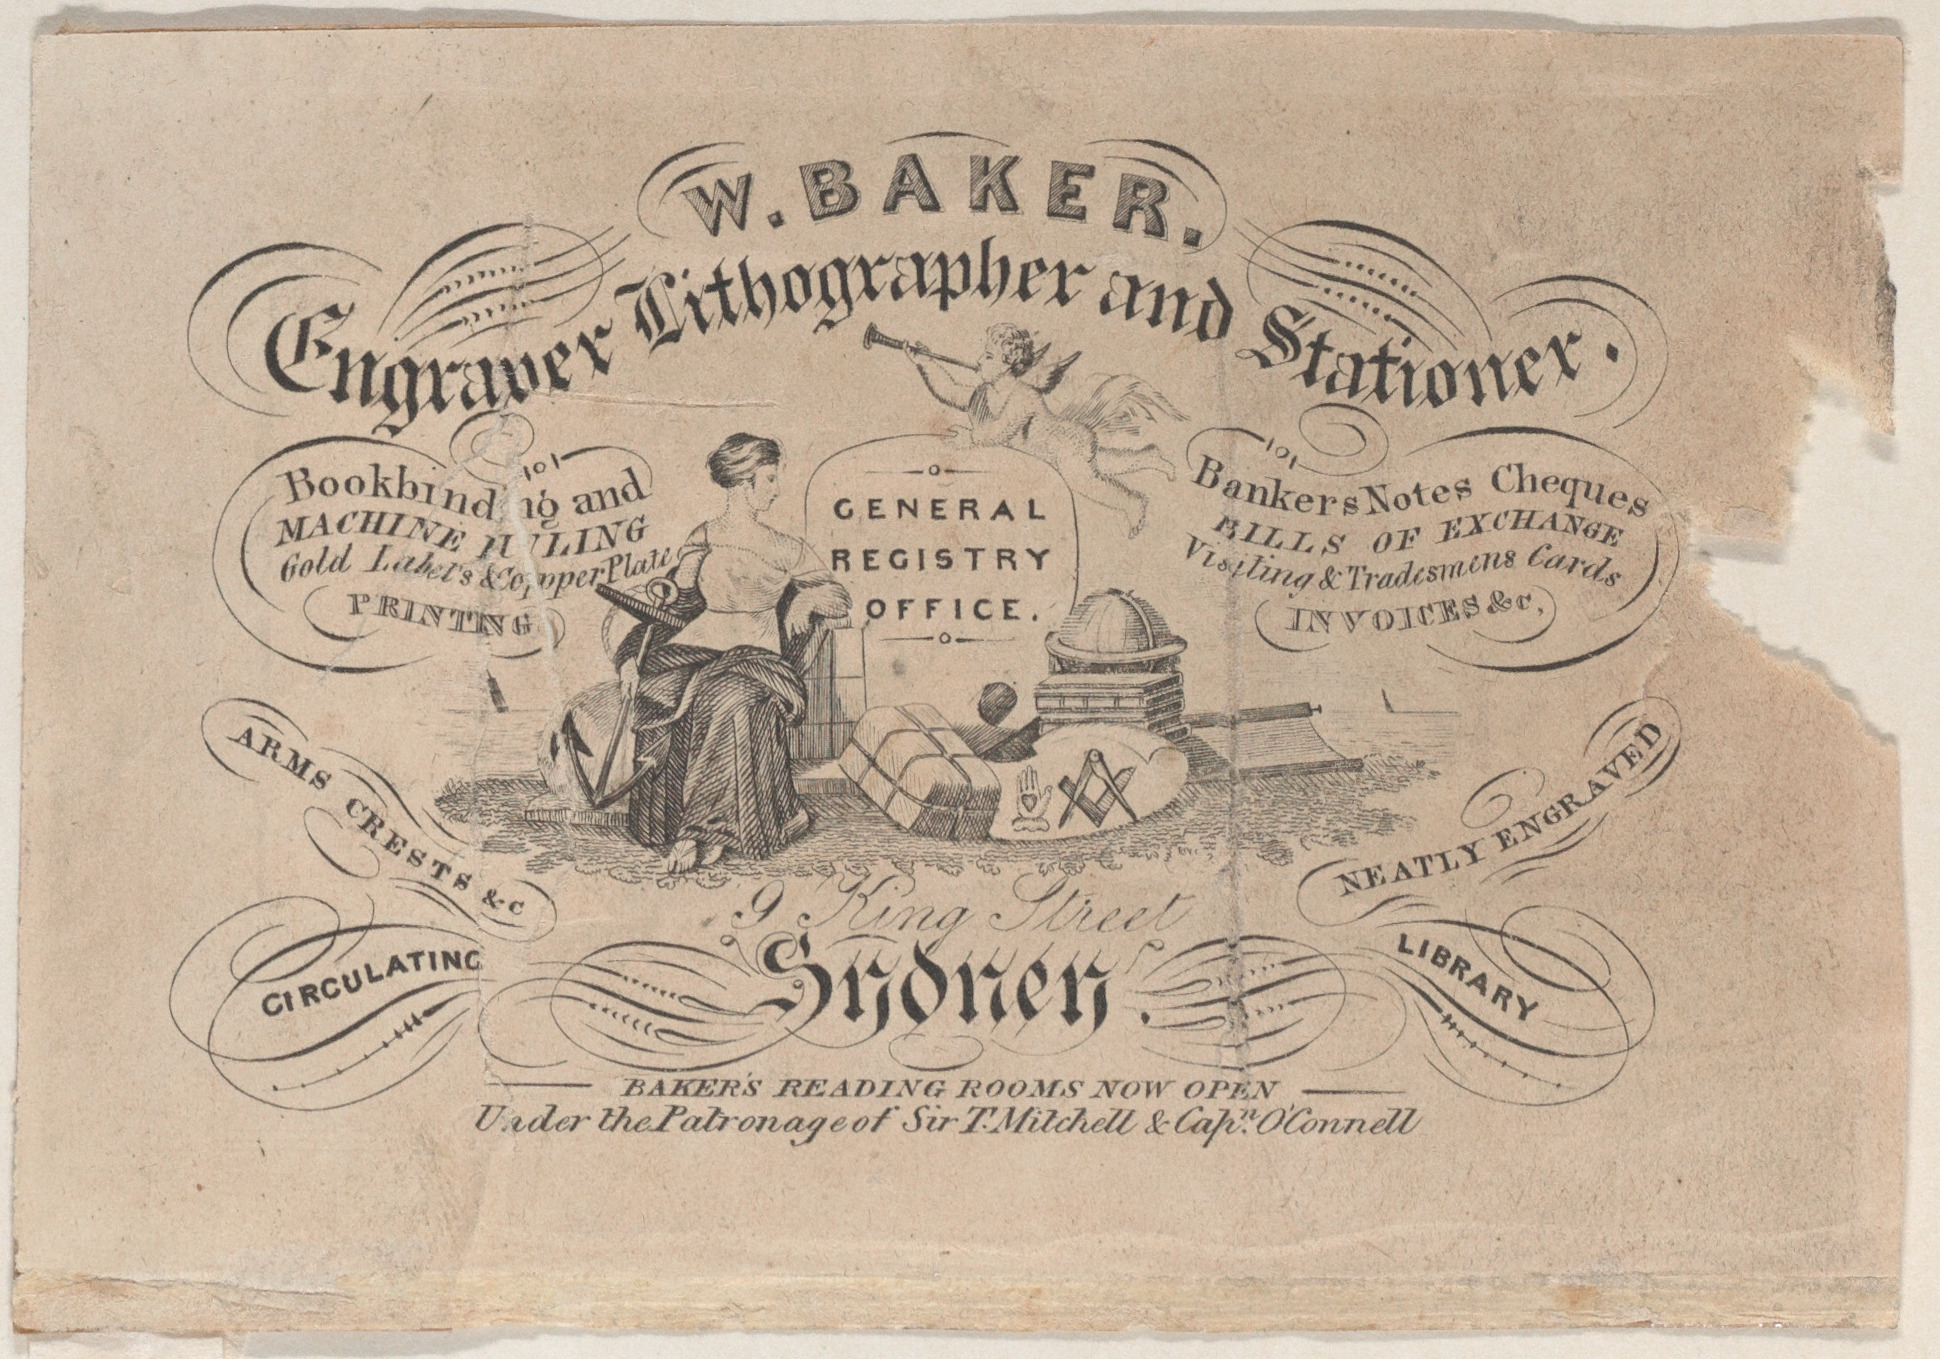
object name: print, trade card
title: Trade Card for W. Baker, Engraver, Lithographer & Stationer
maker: anonymous, british, 19th century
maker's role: artist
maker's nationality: british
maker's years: 1800-1900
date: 1801-1900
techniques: engraving